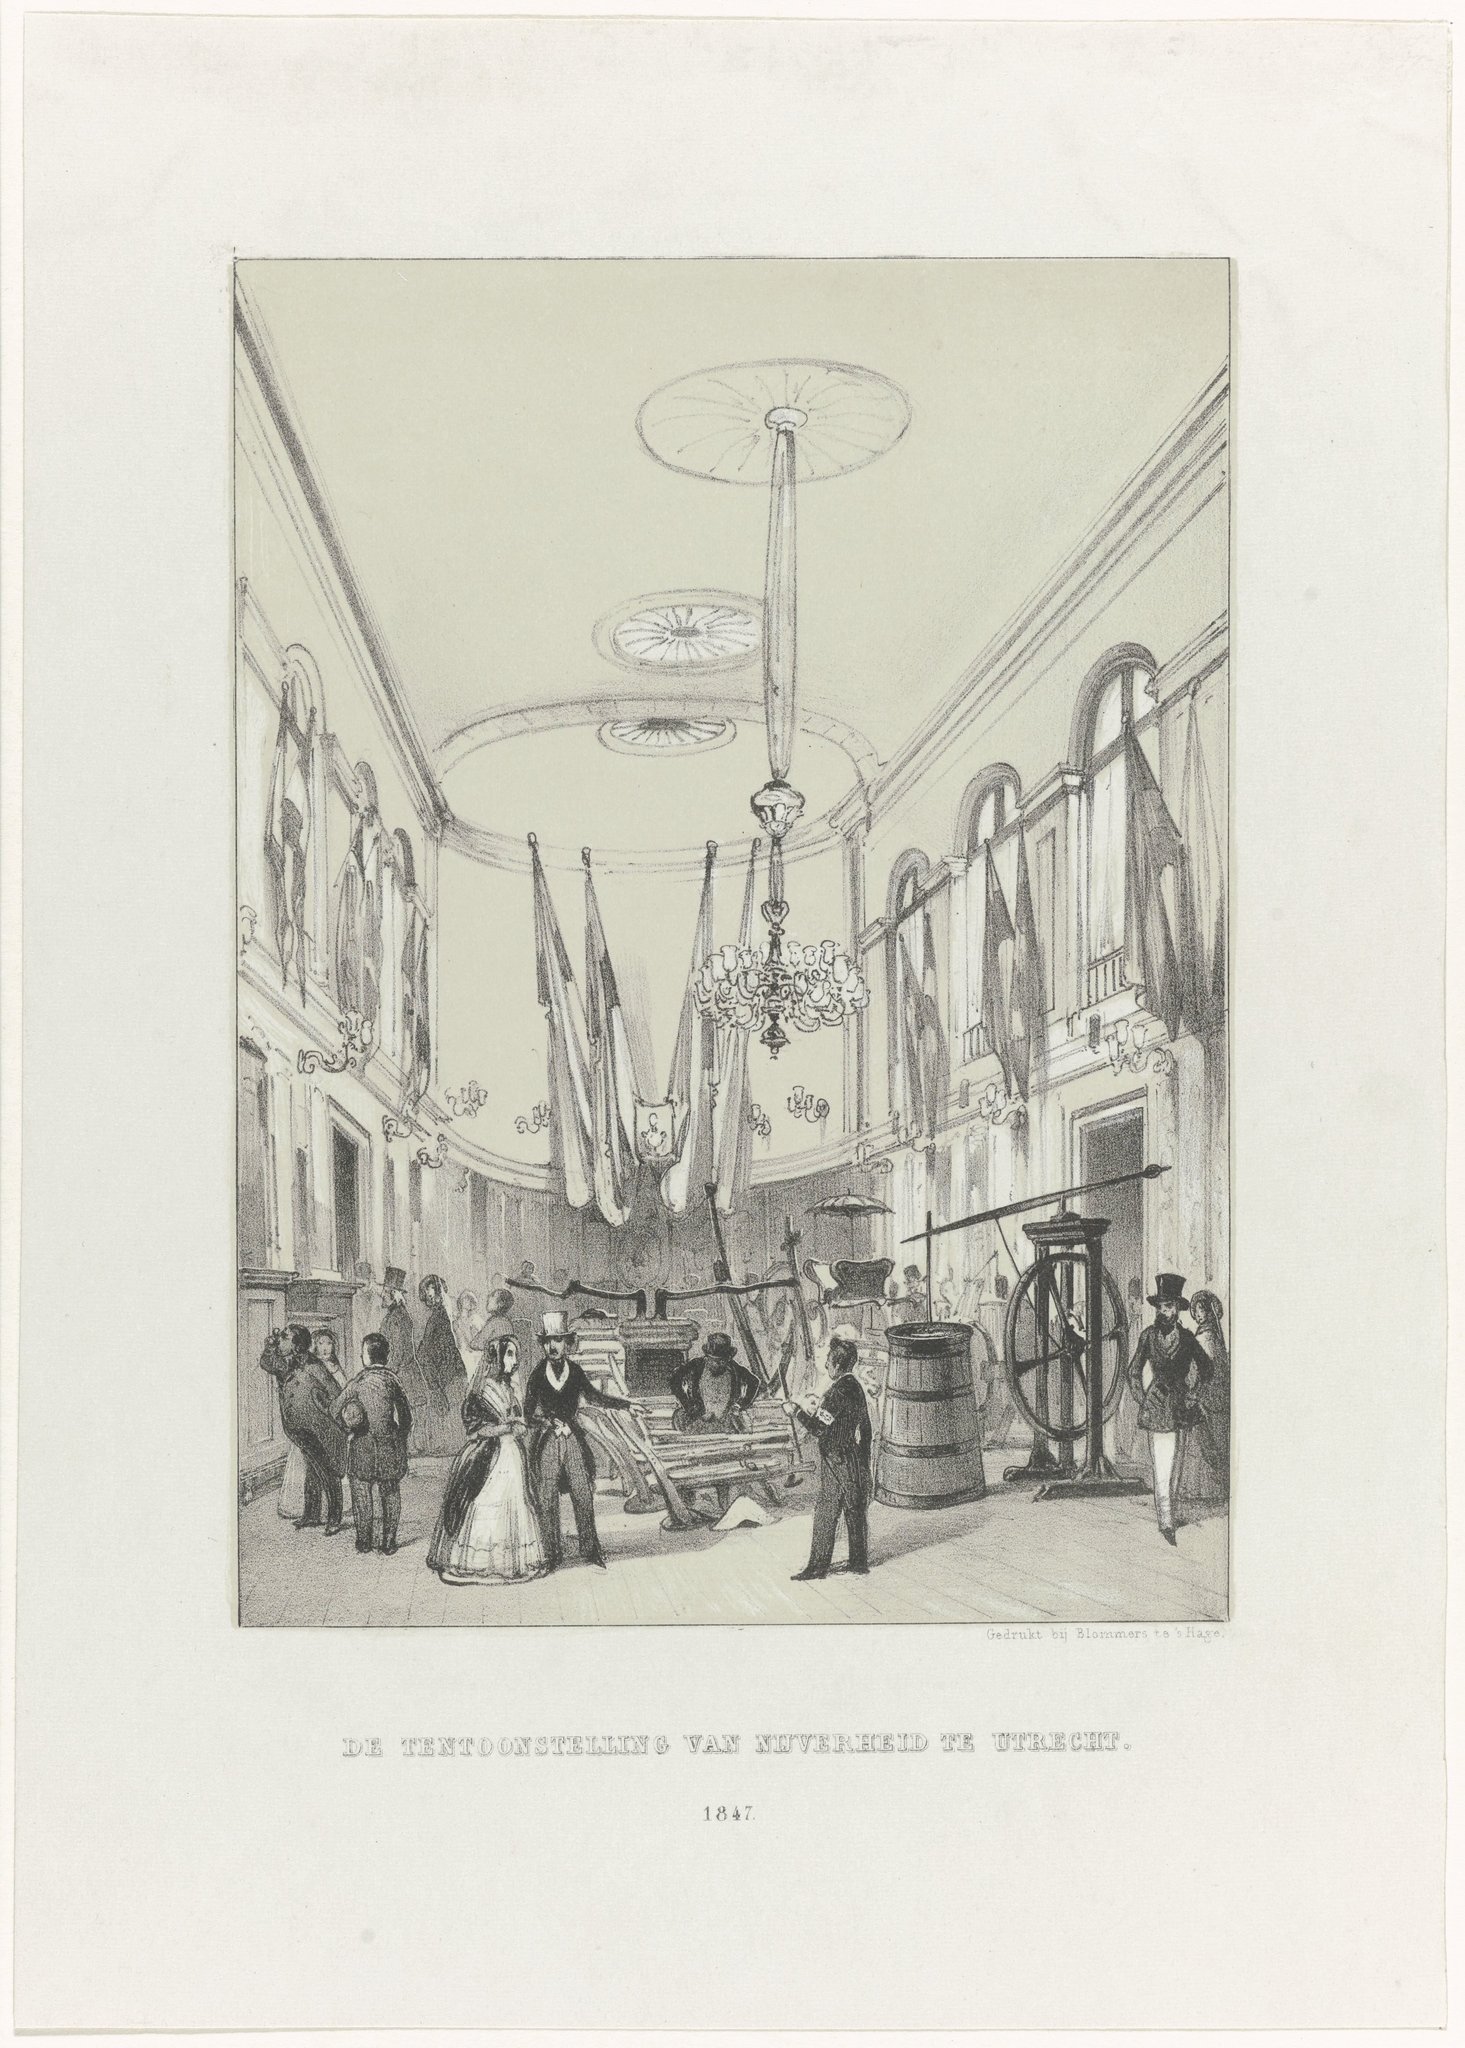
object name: print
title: De tentoonstelling van nijverheid te Utrecht. 1847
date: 1847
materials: paper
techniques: tone lithography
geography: netherlands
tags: trade exhibition, industries fair, utrecht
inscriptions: collector's mark: Lugt 2228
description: De tijd : merkwaardigheden der letterkunde en geschiedenis van den dag voor de beschaafde wereld : met platen en portretten. 's-Gravenhage : J.L. van der Vliet, jrg. 2, dl. 6, 1847.